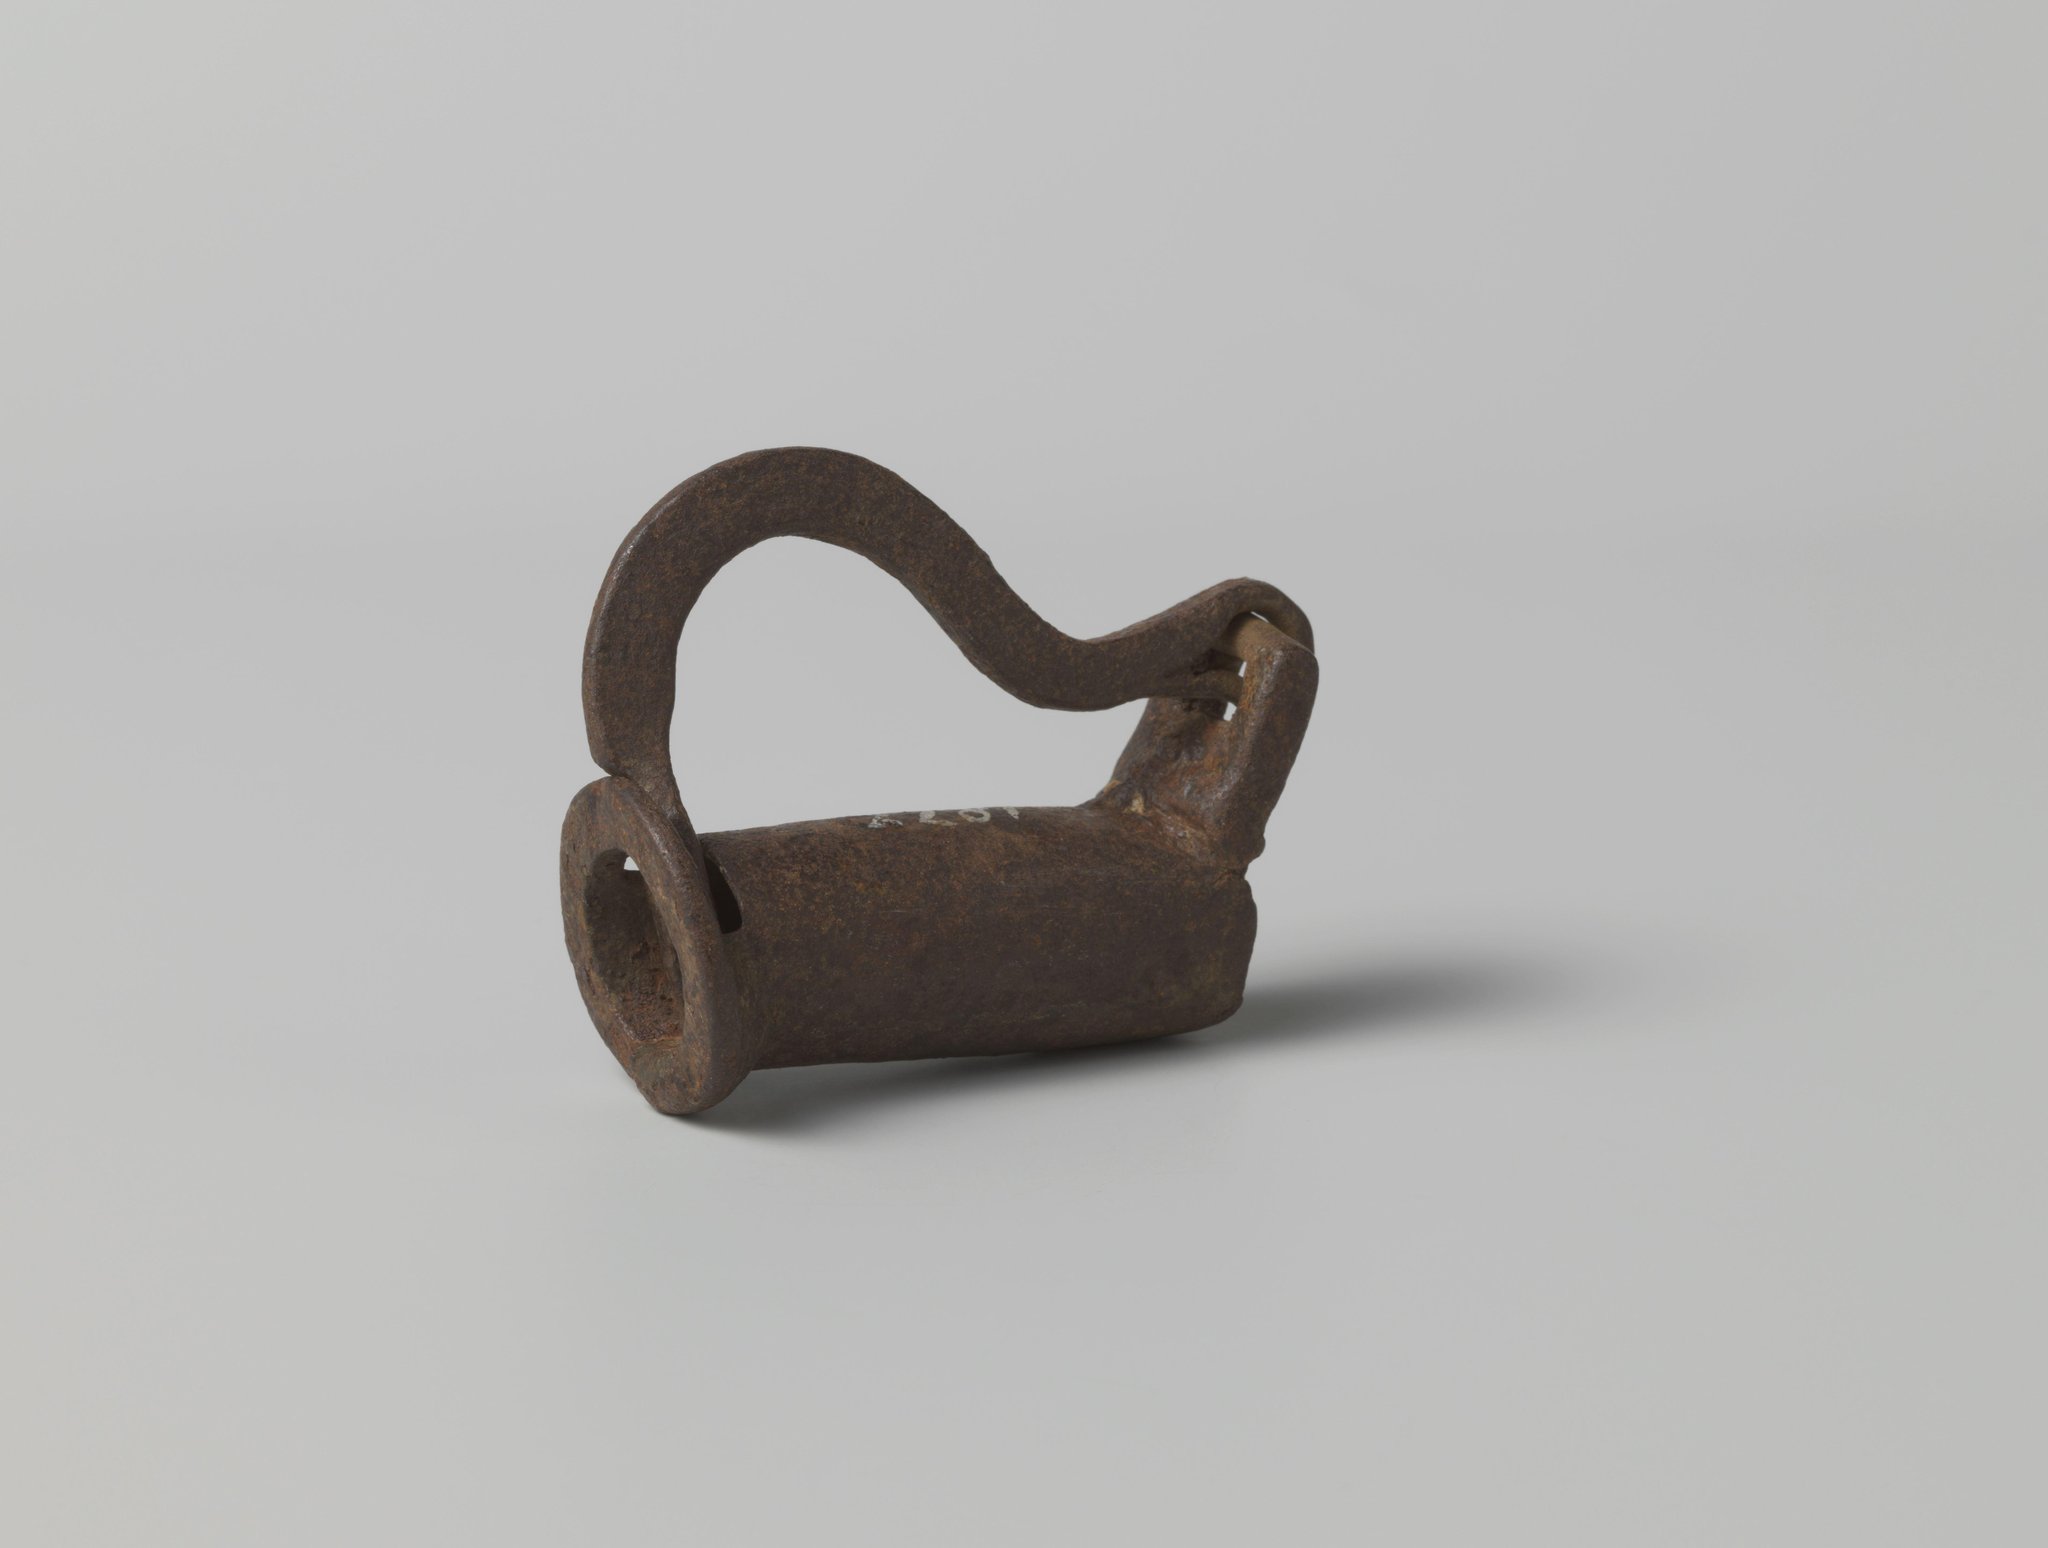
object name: lock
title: Hangslot van ijzer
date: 1400-1950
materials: iron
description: Een ijzeren hangslot waarvan de stuitpen ontbreekt.